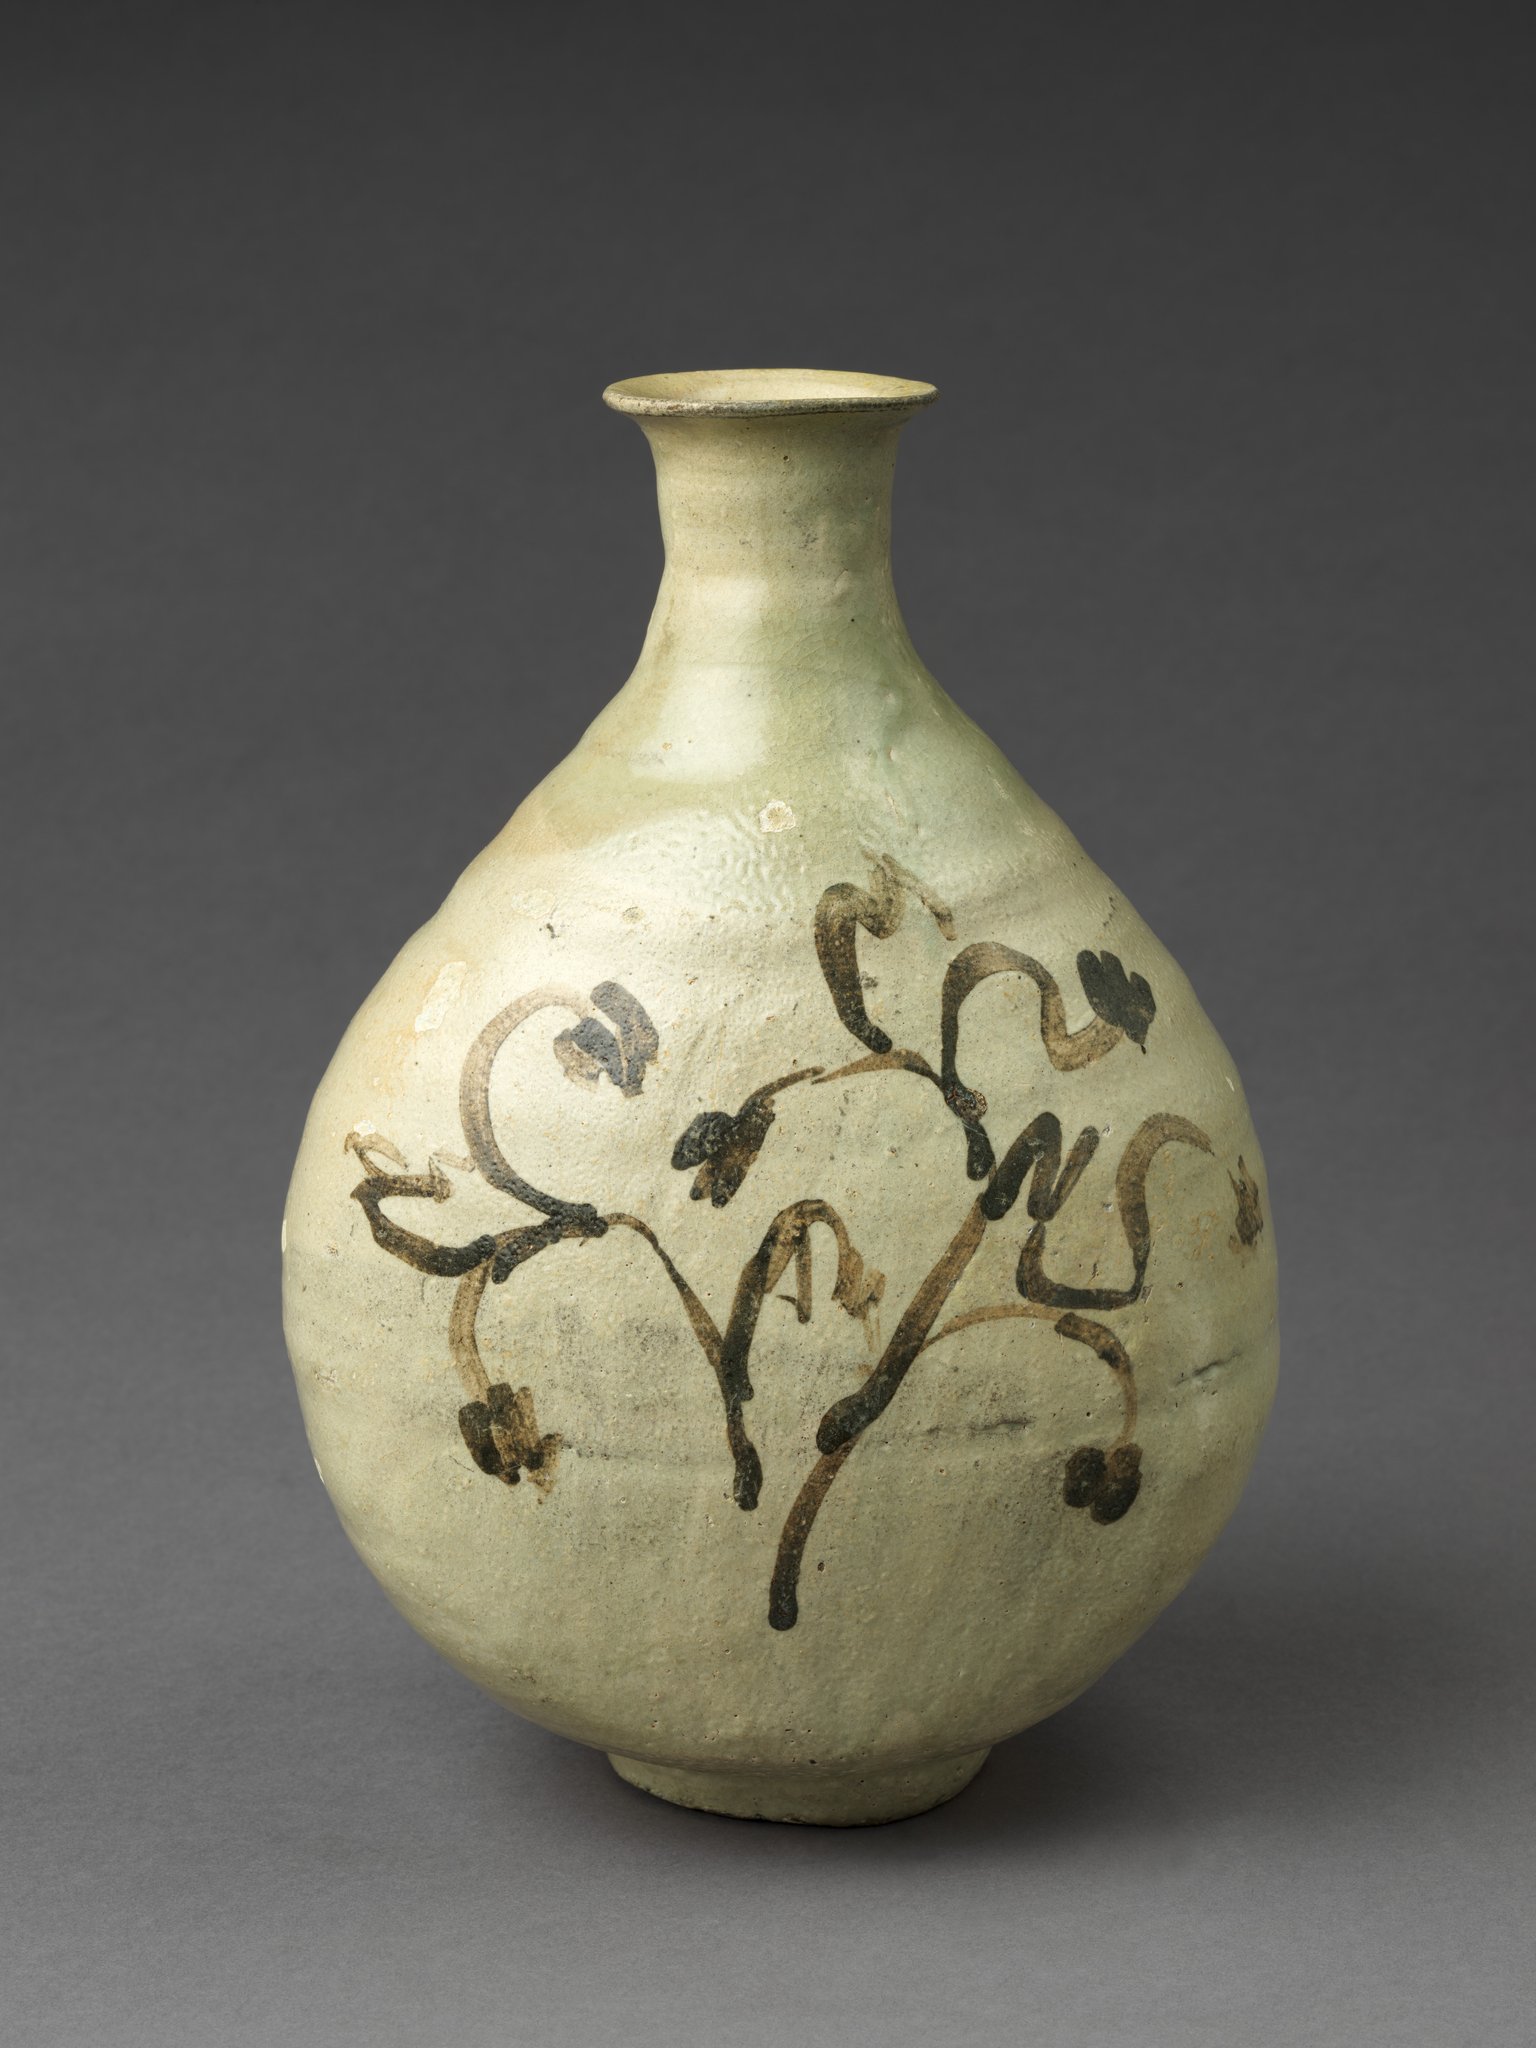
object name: bottle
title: Bottle decorated with flowering plant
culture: korean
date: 1467-1533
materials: iron